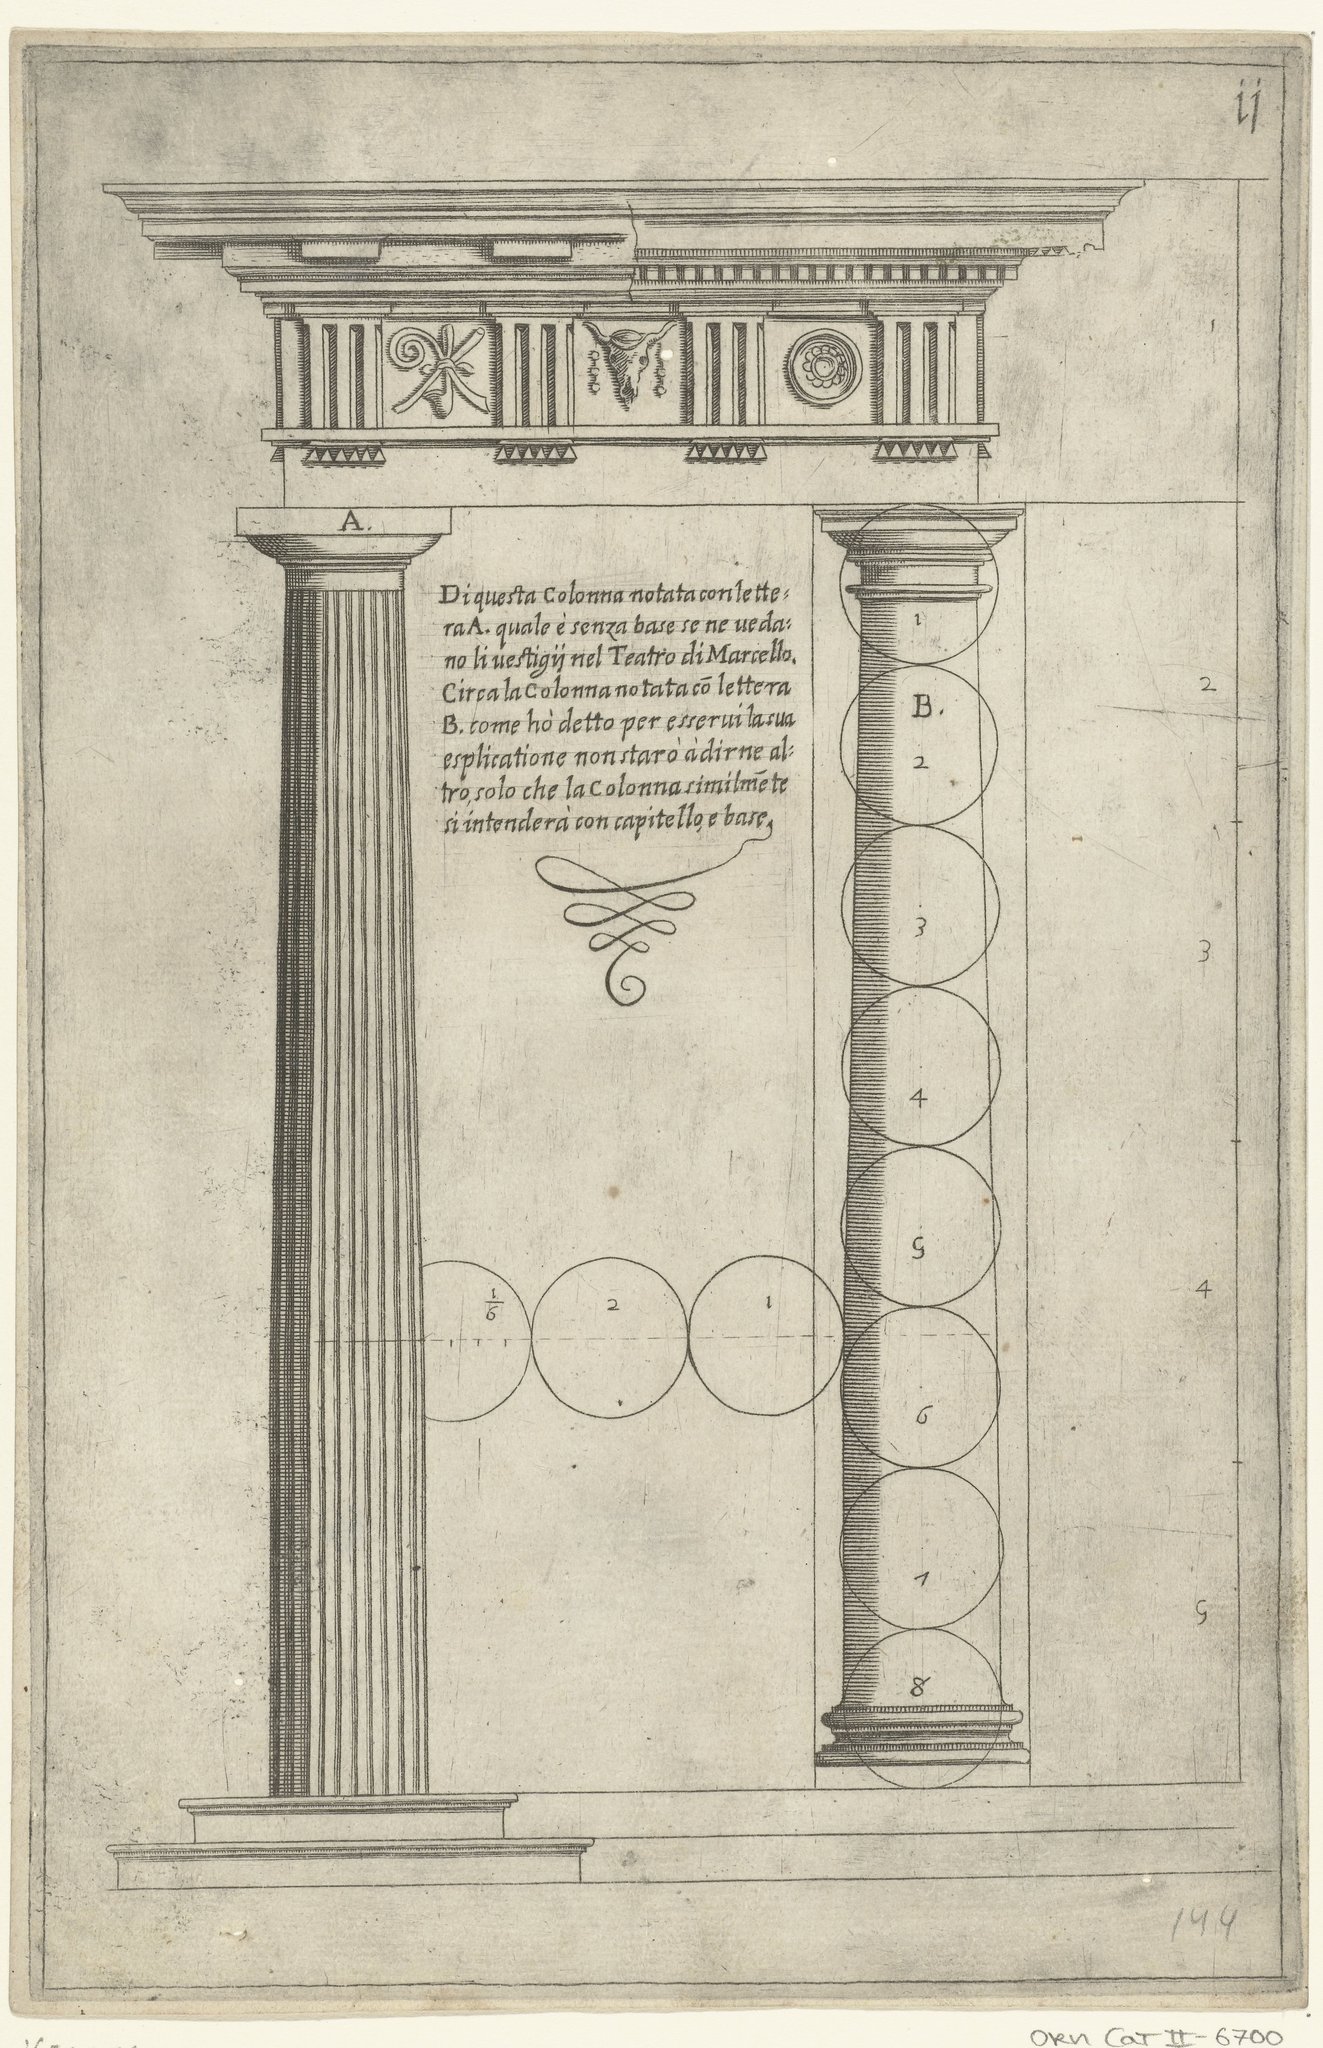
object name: print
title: Architettura con diversi ornamenti cavati dall' Antico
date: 1636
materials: paper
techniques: engraving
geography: rome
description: Midden boven staat uitleg. Uit eerste editie.